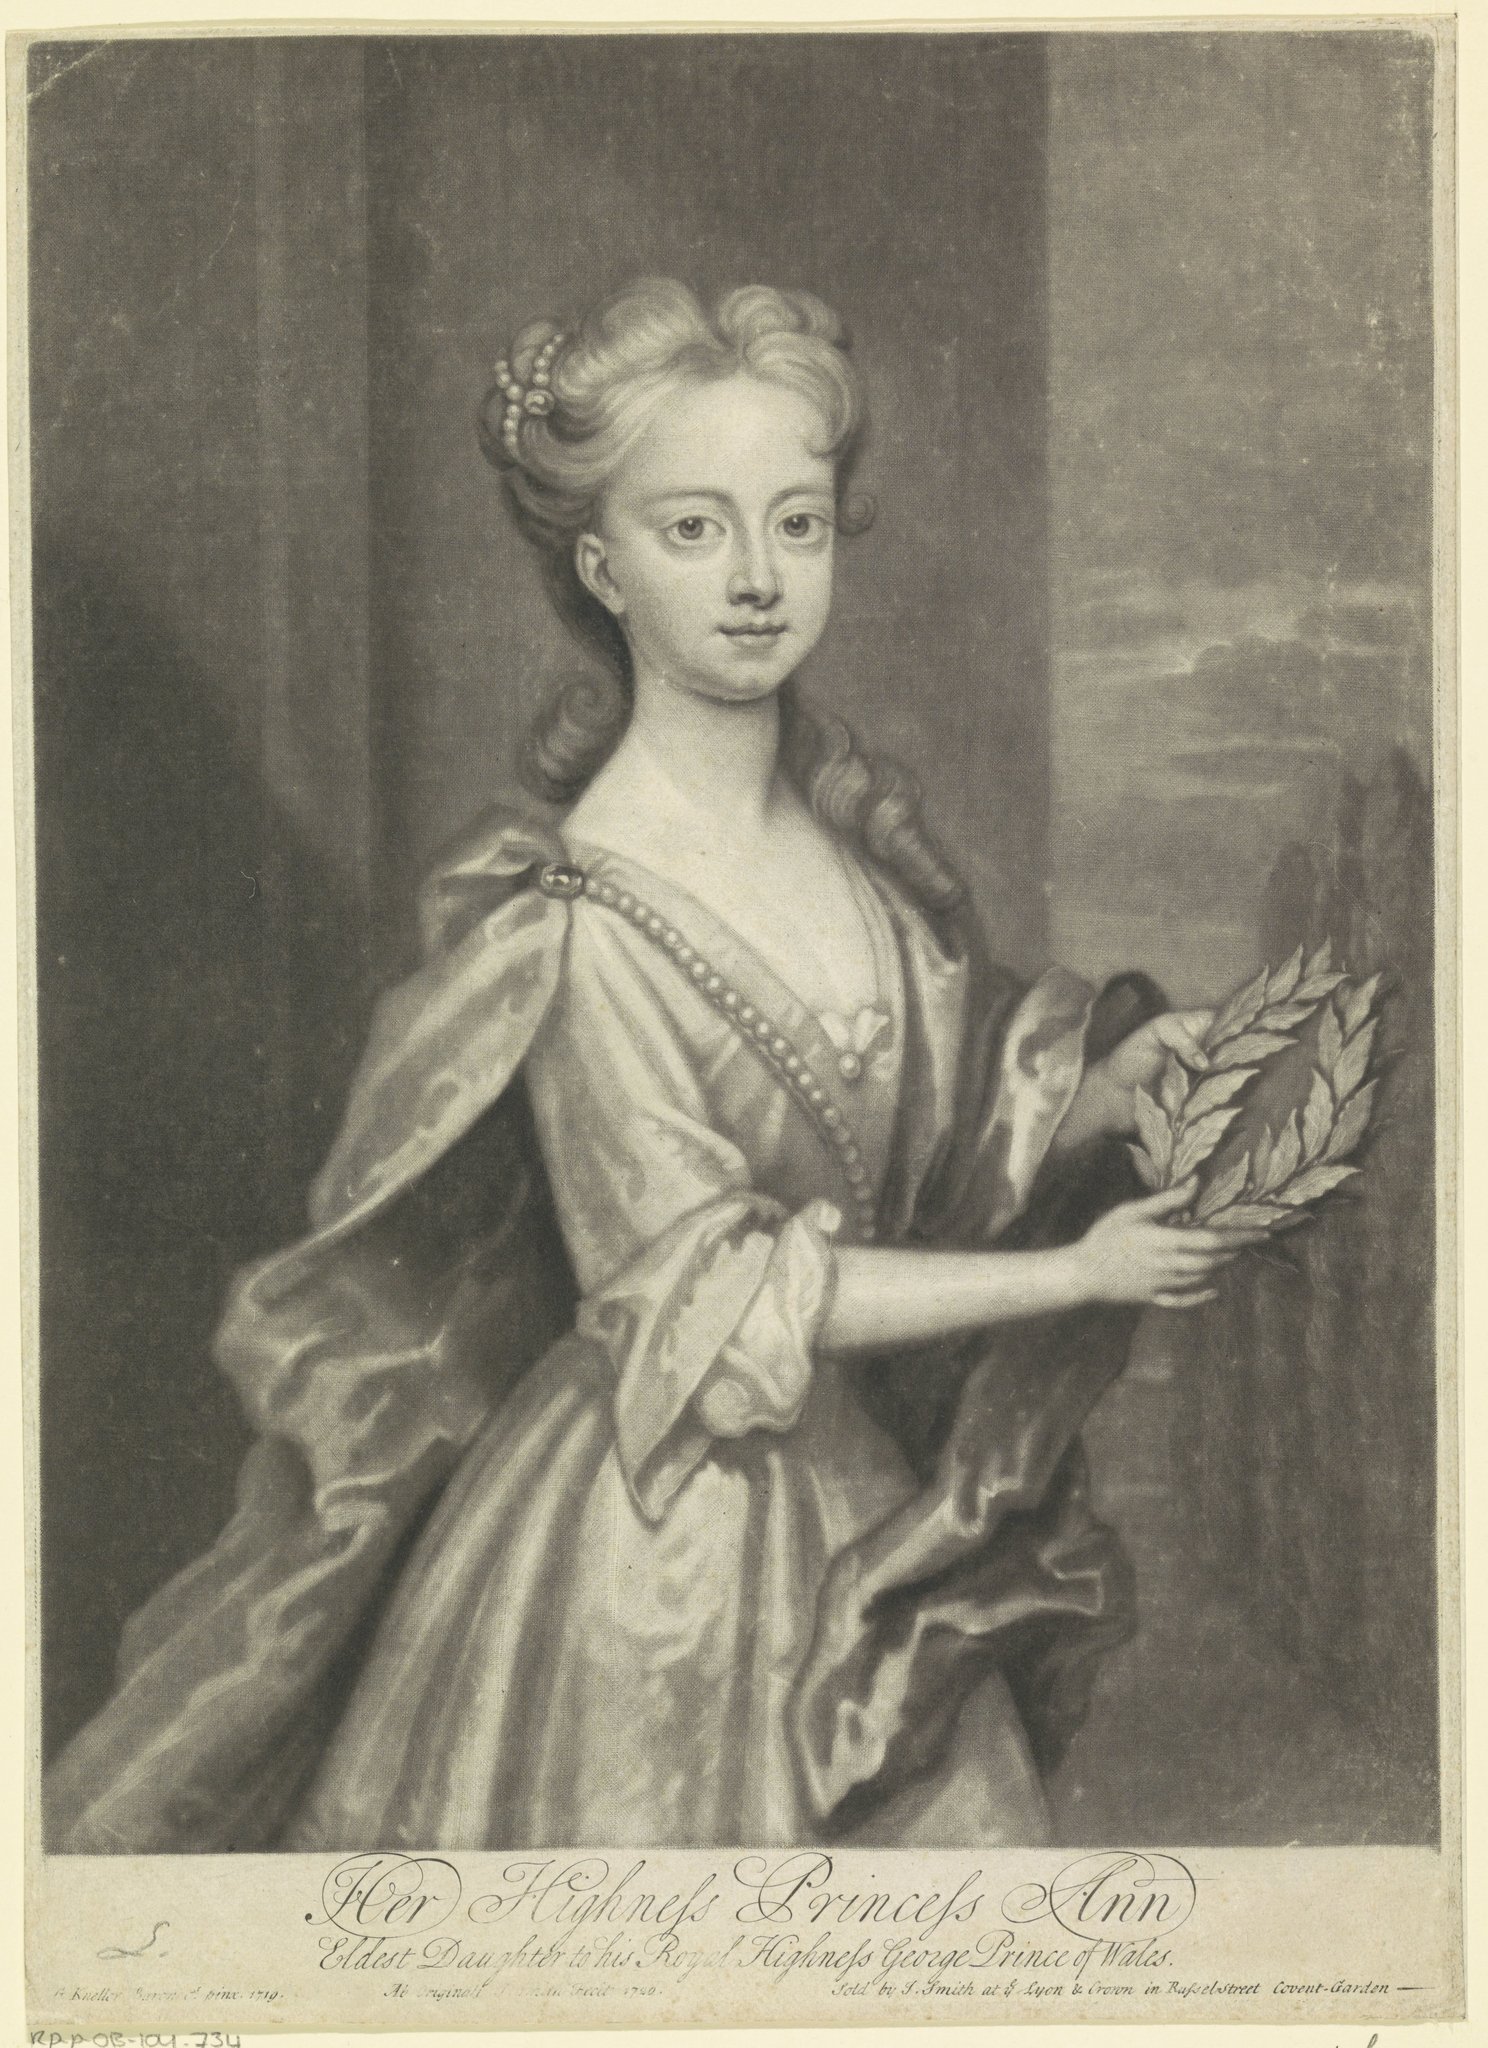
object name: print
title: Portret van Anna van Hannover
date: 1720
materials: paper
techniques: mezzotint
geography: london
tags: anna van hannover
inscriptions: collector's mark: Lugt 2228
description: Portret van Anna. In haar handen een lauwerkrans. In de ondermarge twee regels Engelse tekst.